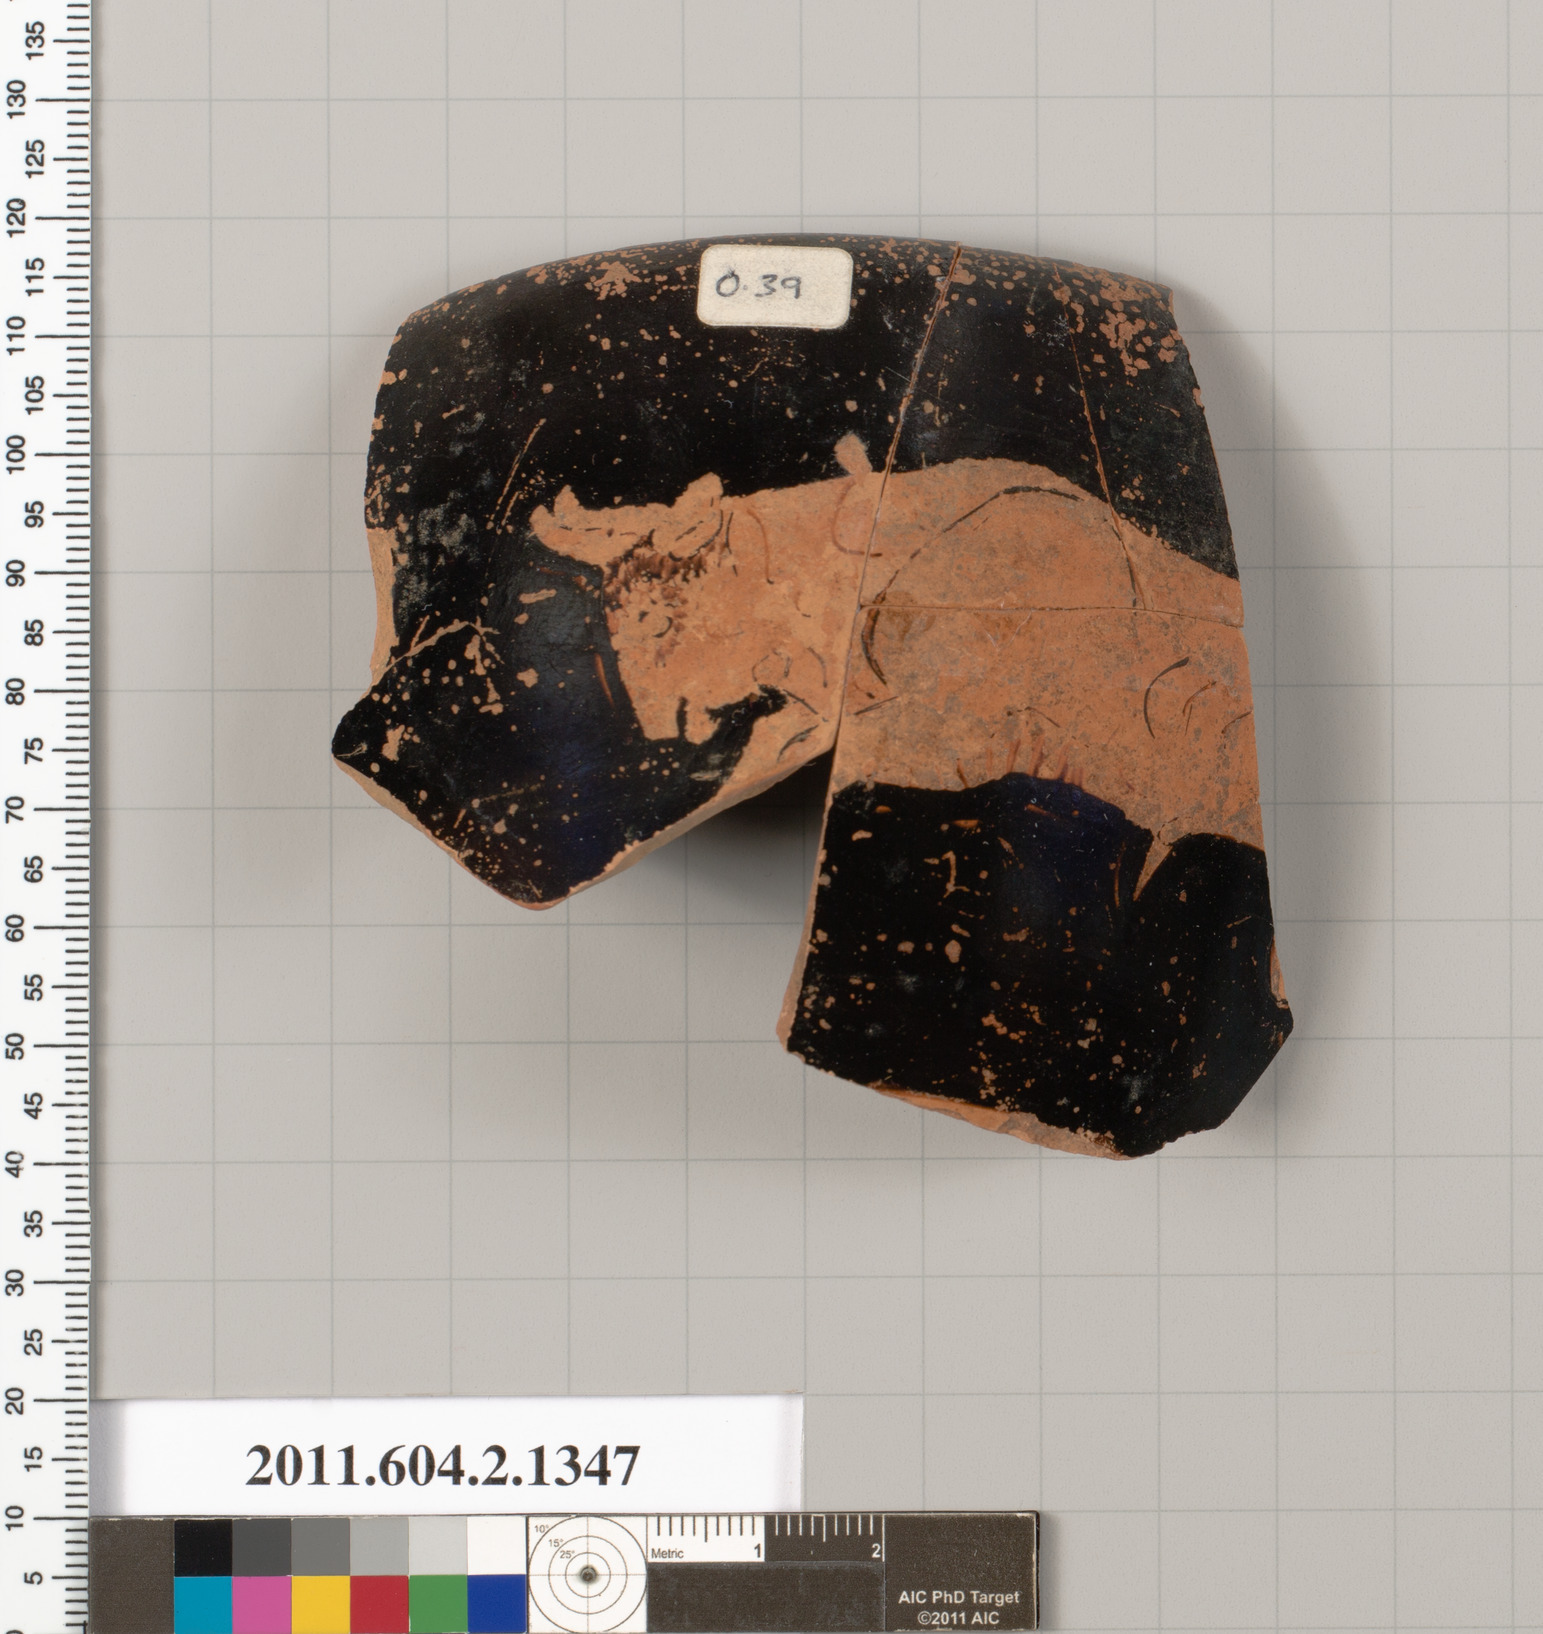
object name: skyphos fragment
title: Terracotta fragment of a skyphos (deep drinking cup)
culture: greek, attic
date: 450-426 BCE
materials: terracotta